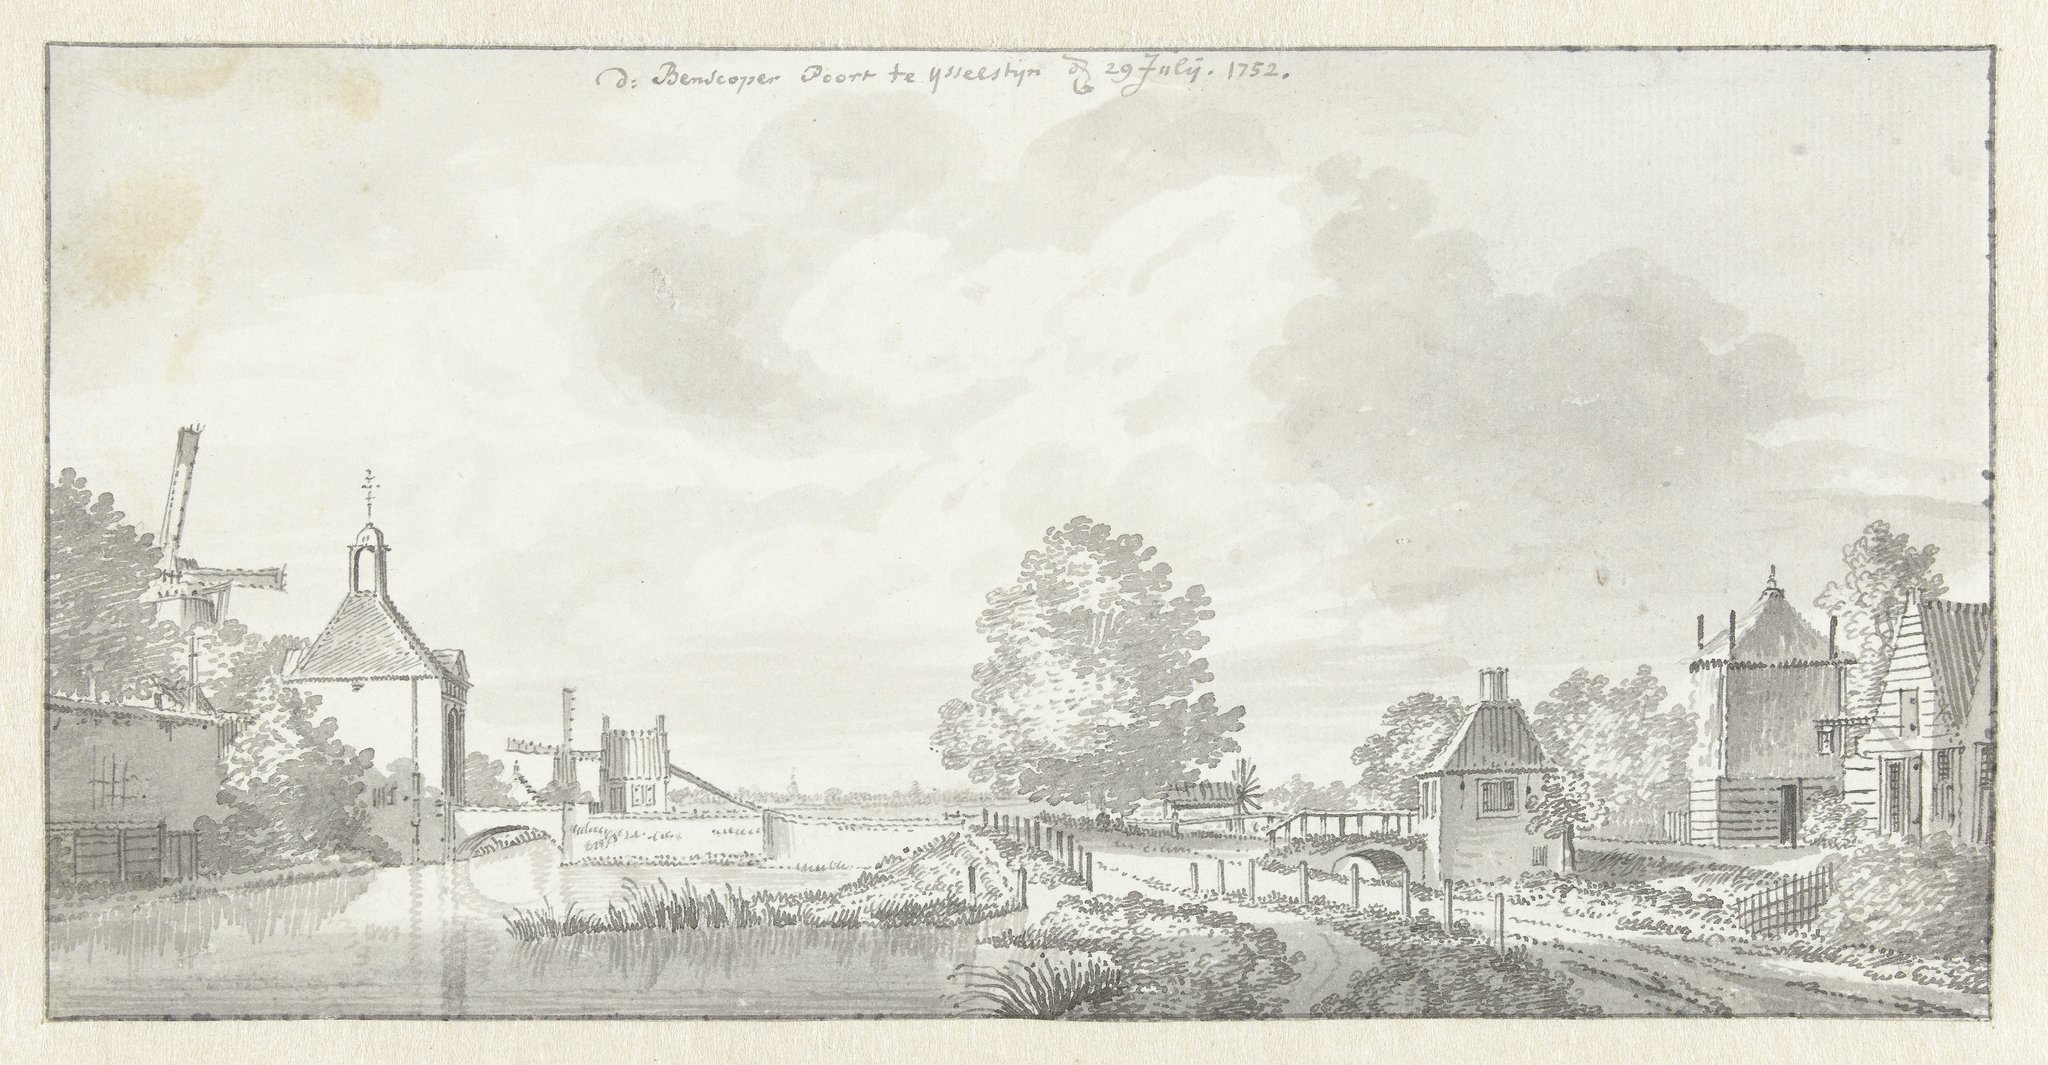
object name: drawing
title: De Benscoper Poort te IJsselstein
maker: jan de beijer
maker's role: draughtsman, print maker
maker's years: 1703-1780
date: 1752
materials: ink, paper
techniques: brush, pen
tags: city-gate, public road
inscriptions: : ‘Benscoper Poort’